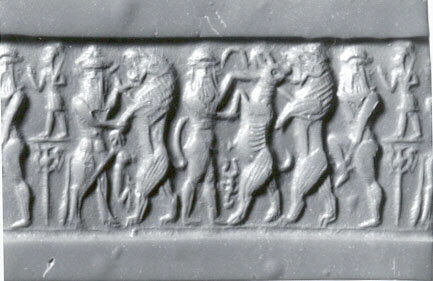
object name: cylinder seal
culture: babylonian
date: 1800-1625 BCE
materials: mineral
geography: mesopotamia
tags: men,lions